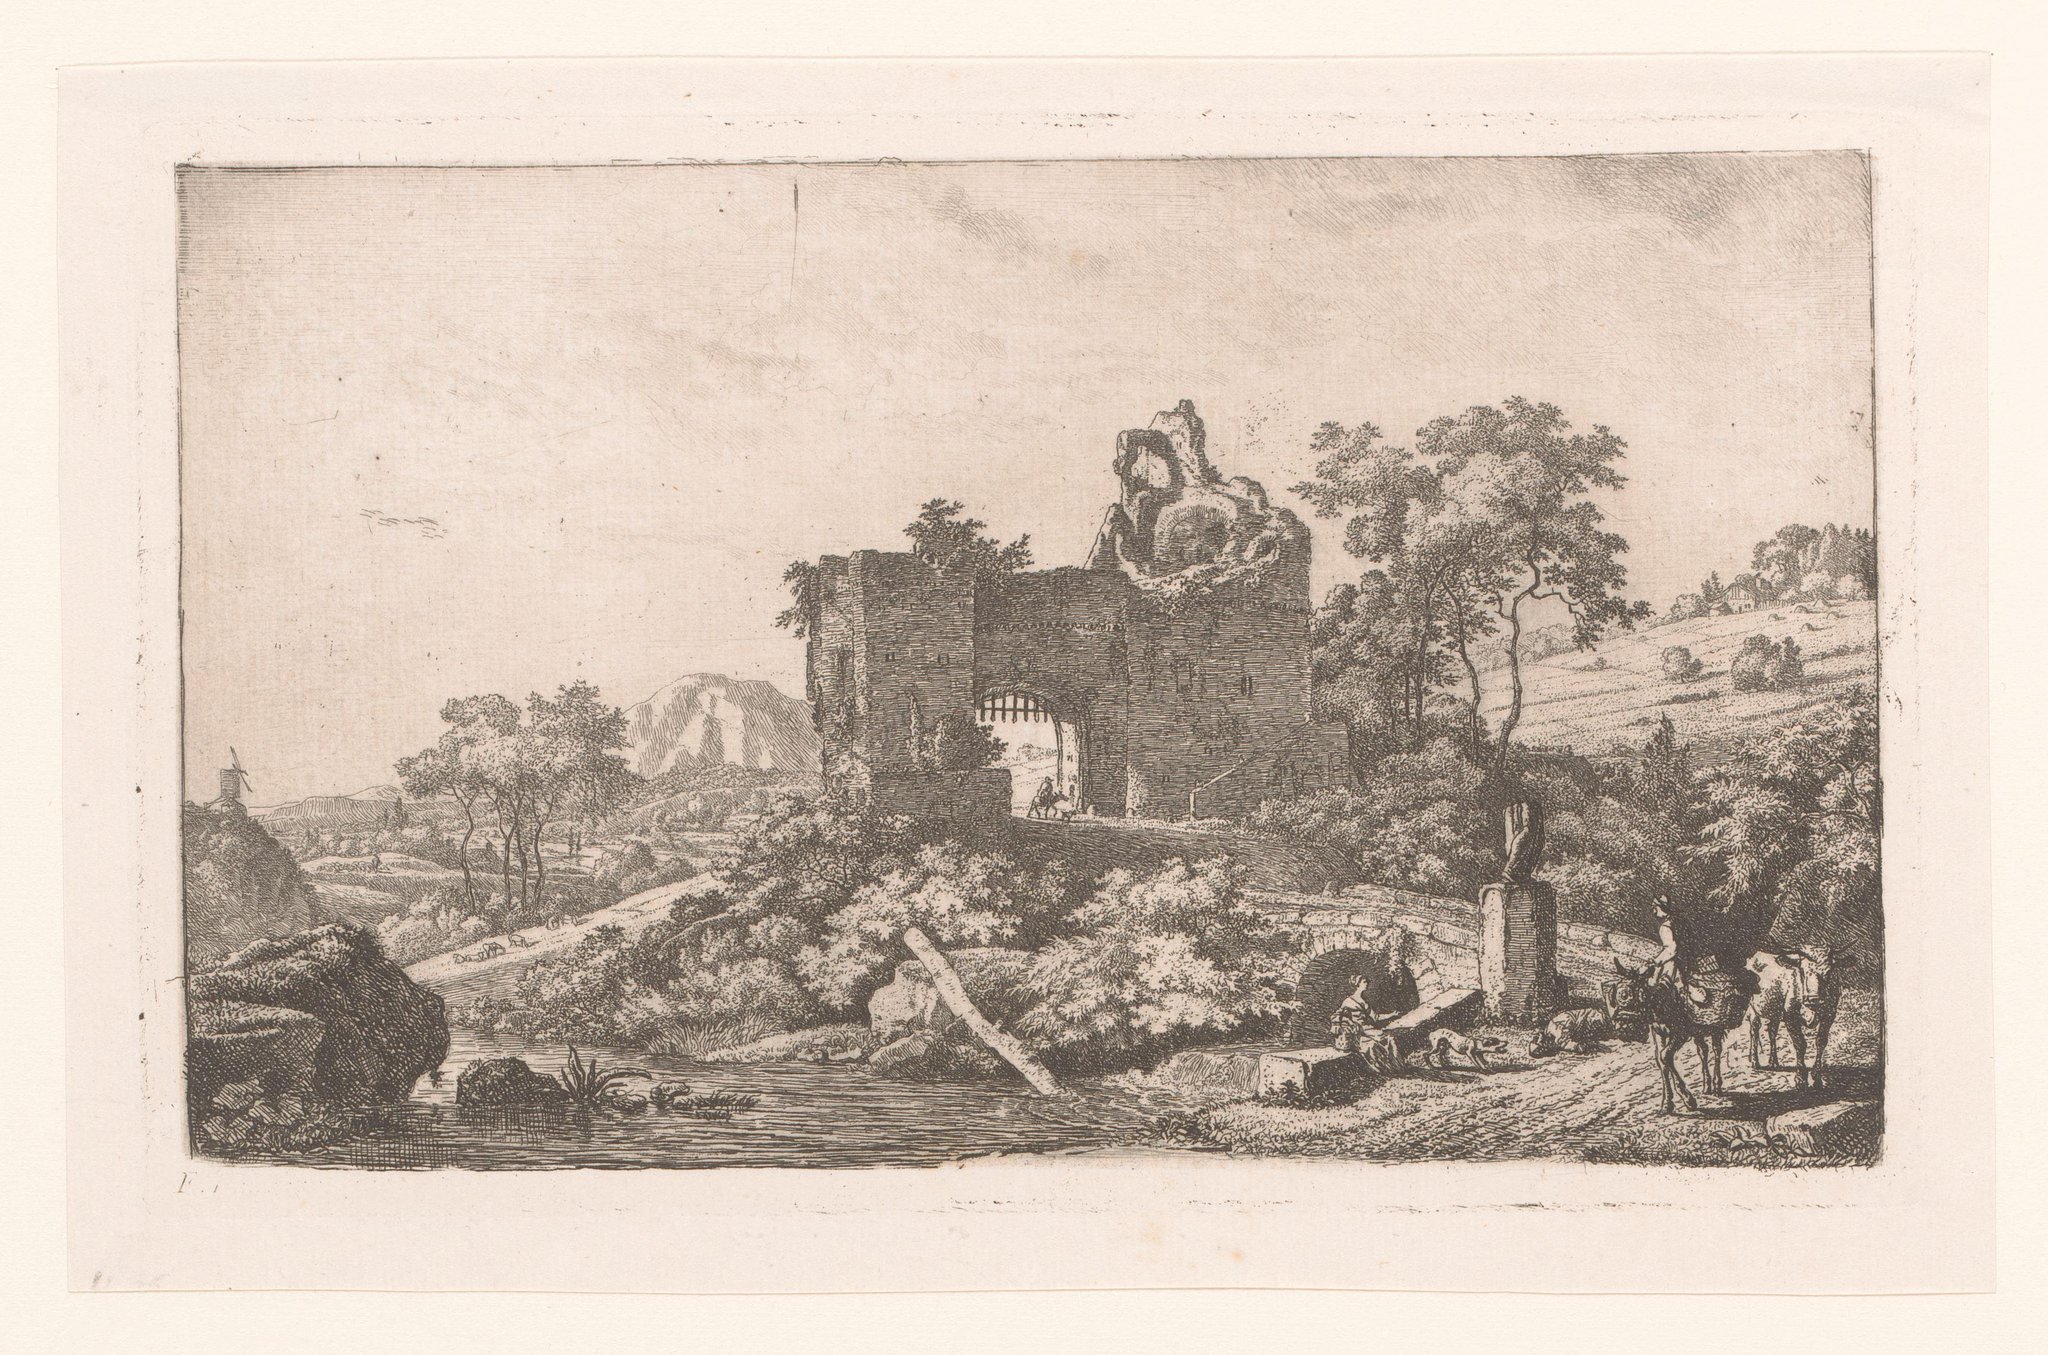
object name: print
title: Landschap met ruïne van een poort en figuren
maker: jean louis demarne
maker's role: draughtsman, painter, print maker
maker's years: 1752-1829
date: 1762-1829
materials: paper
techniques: etching, intaglio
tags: gate ~ fortified city, landscape with ruins (+ city(-scape) with figures, staffage)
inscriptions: collector's mark: Lugt 2228